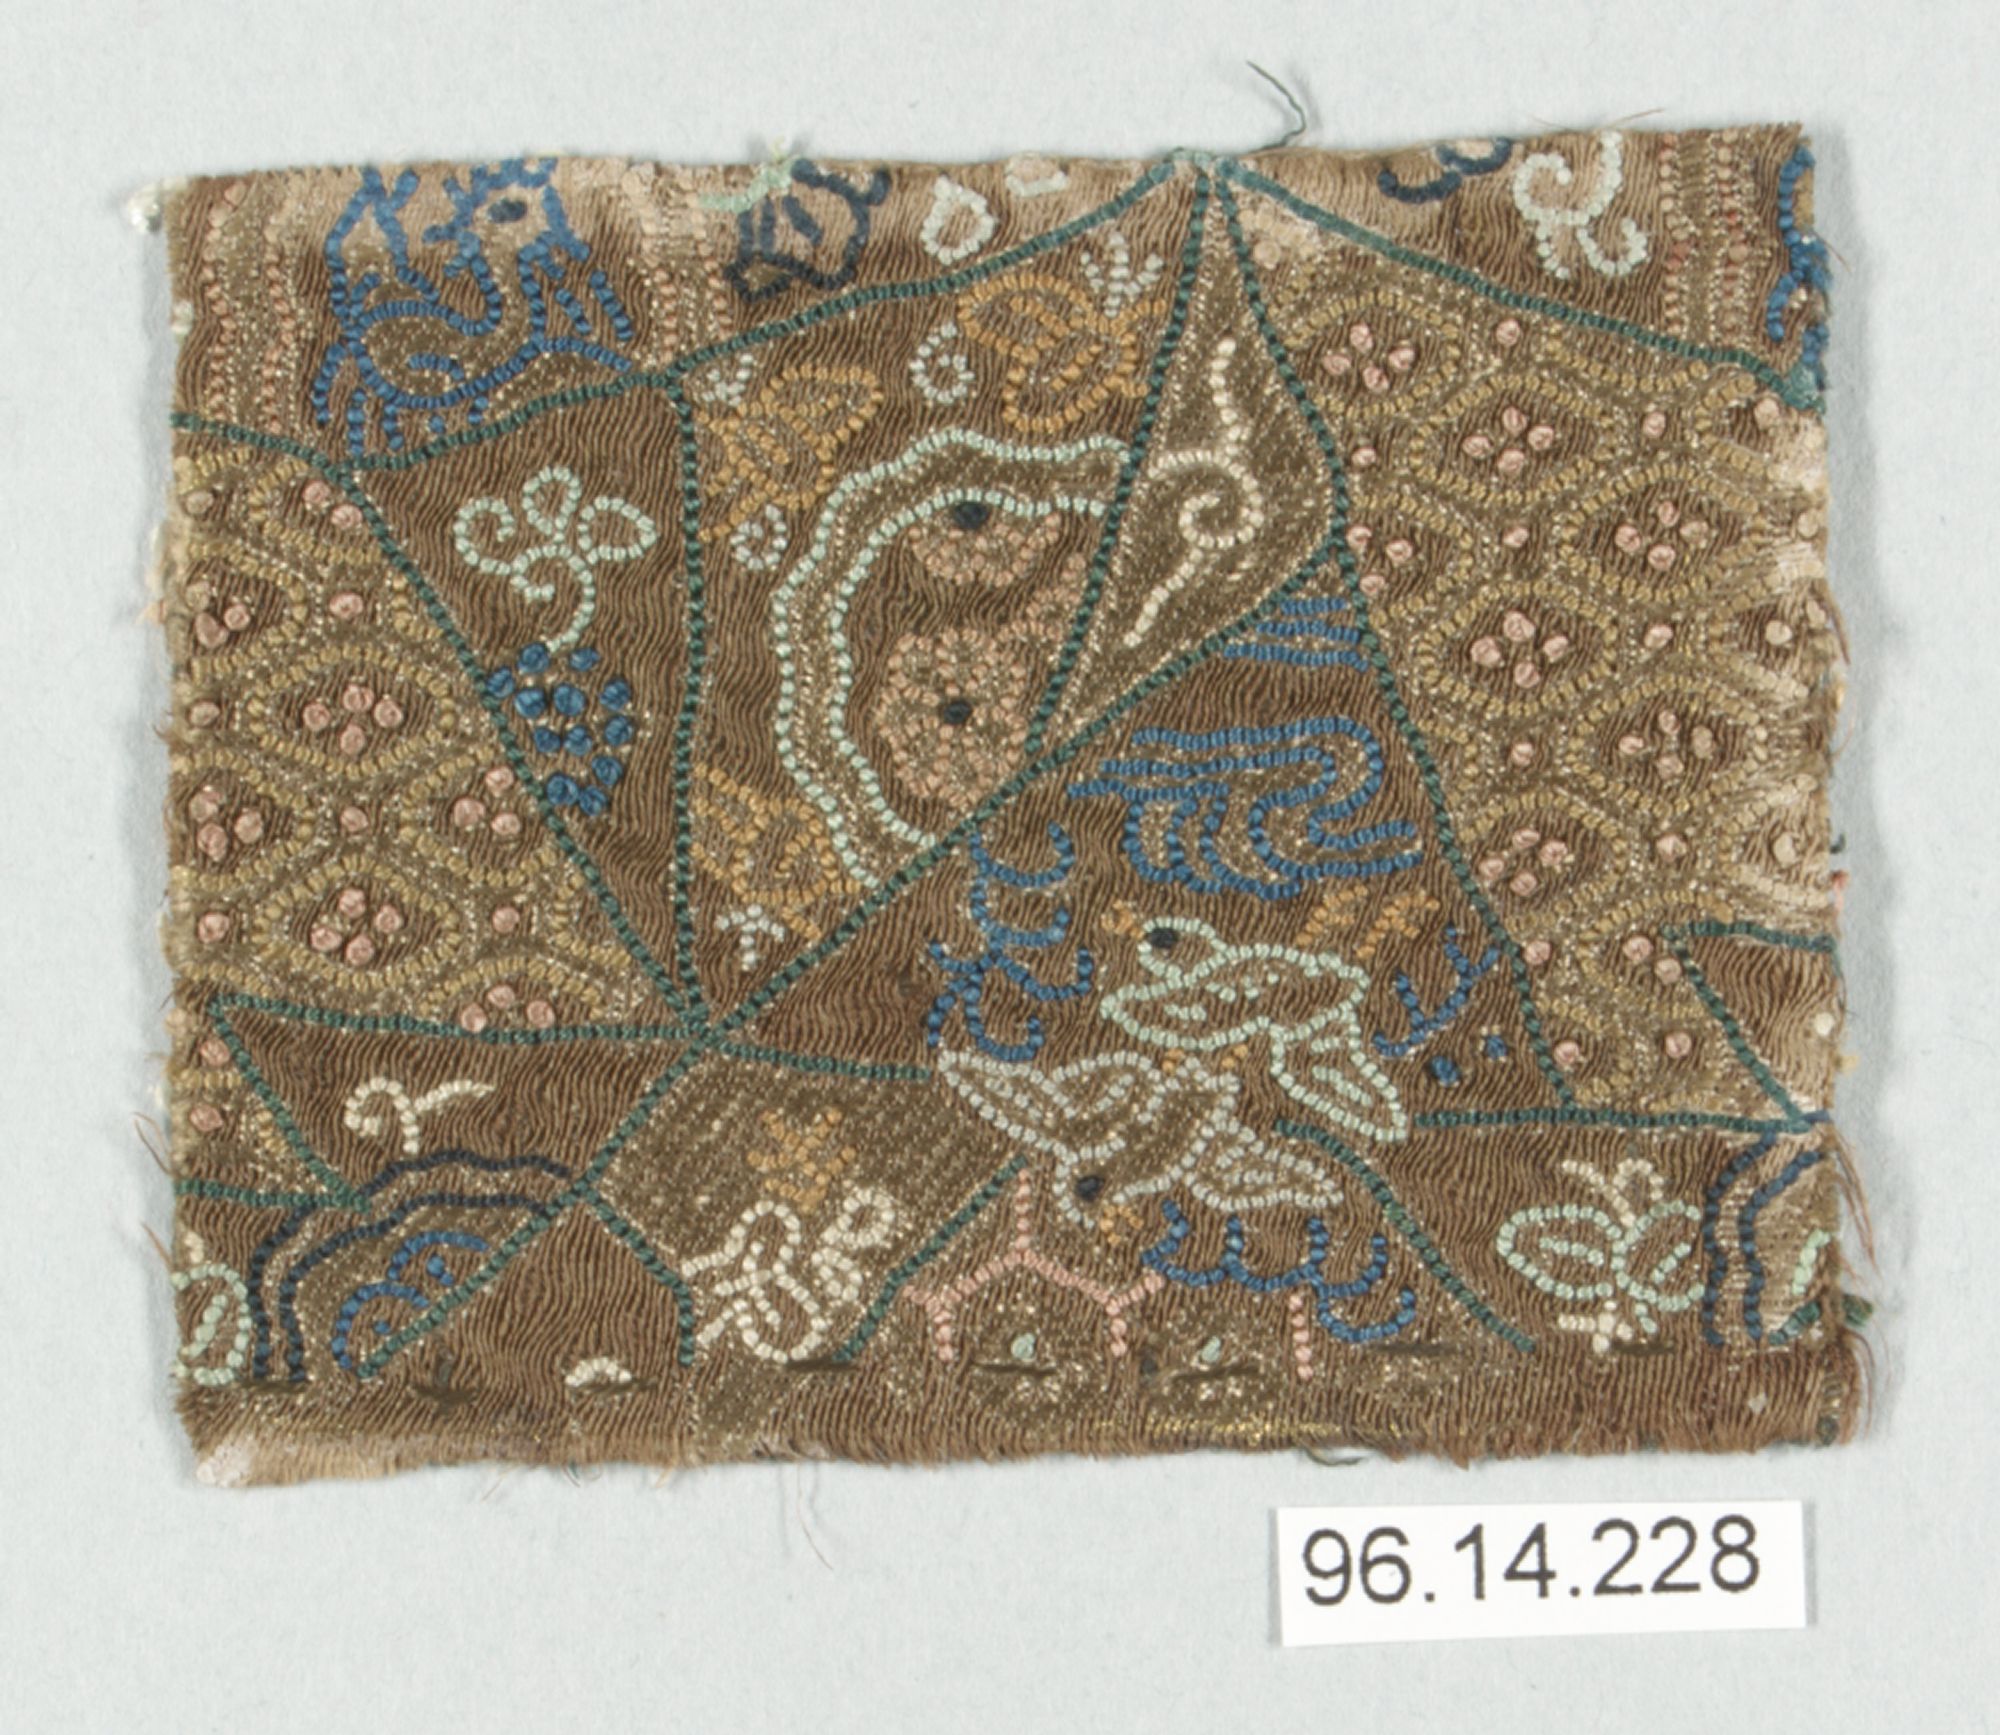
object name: piece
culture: japanese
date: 1701-1800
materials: cotton, silk